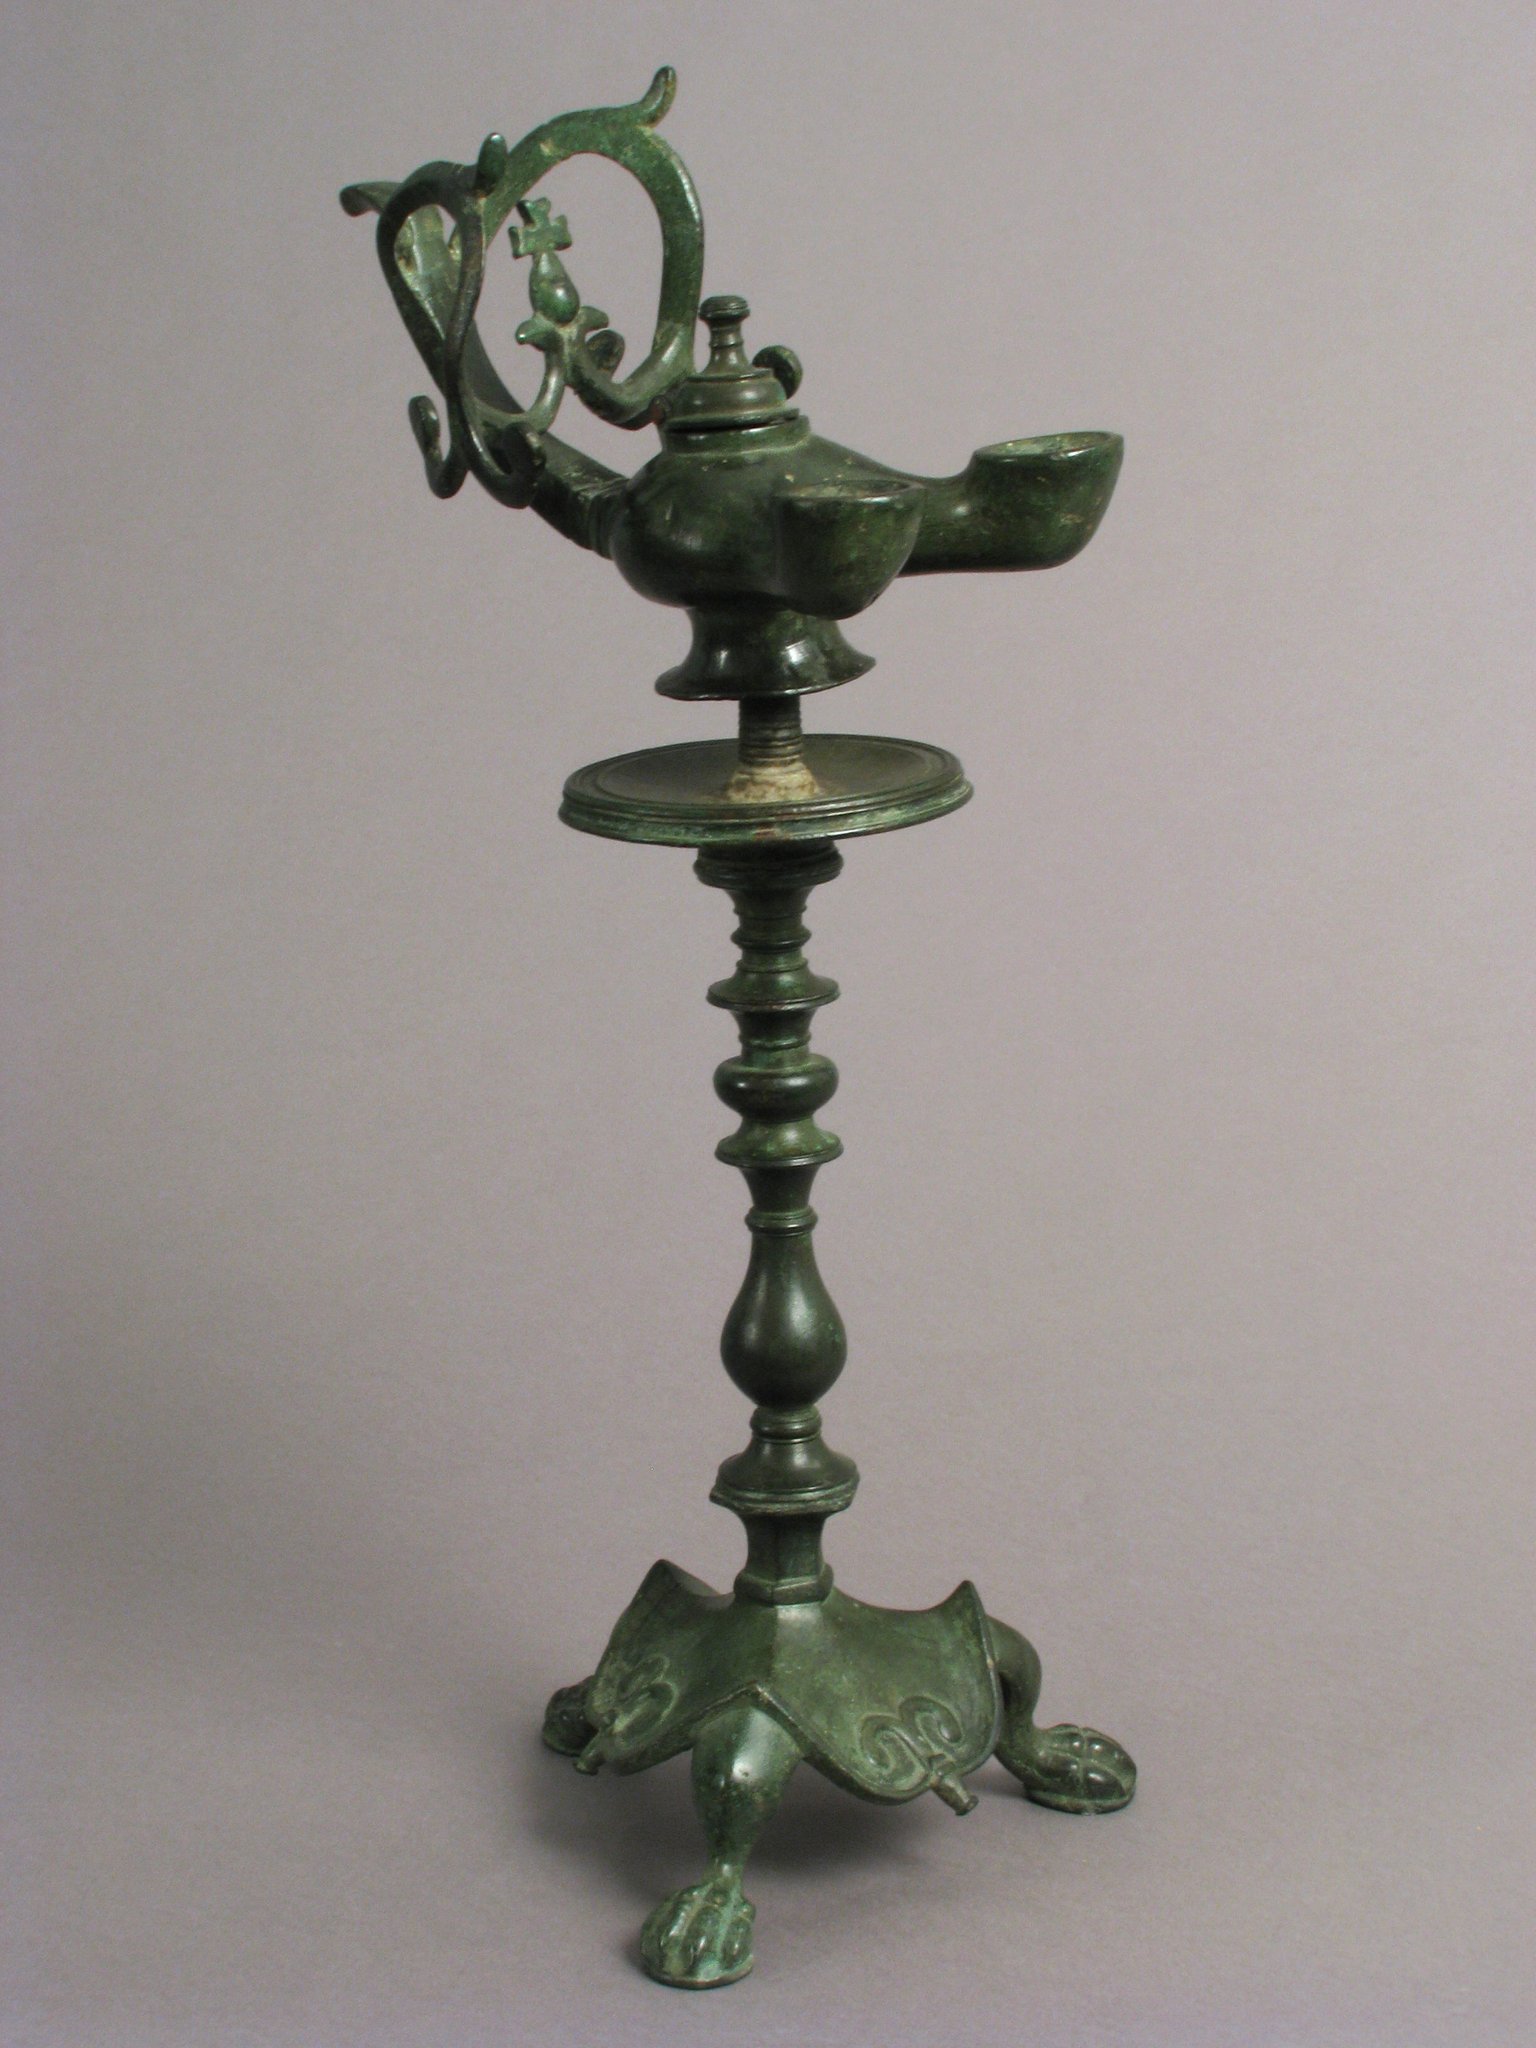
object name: lamp stand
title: Standing Lamp with a Cross on a Pricket Stand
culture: byzantine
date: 401-500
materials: copper alloy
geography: syria